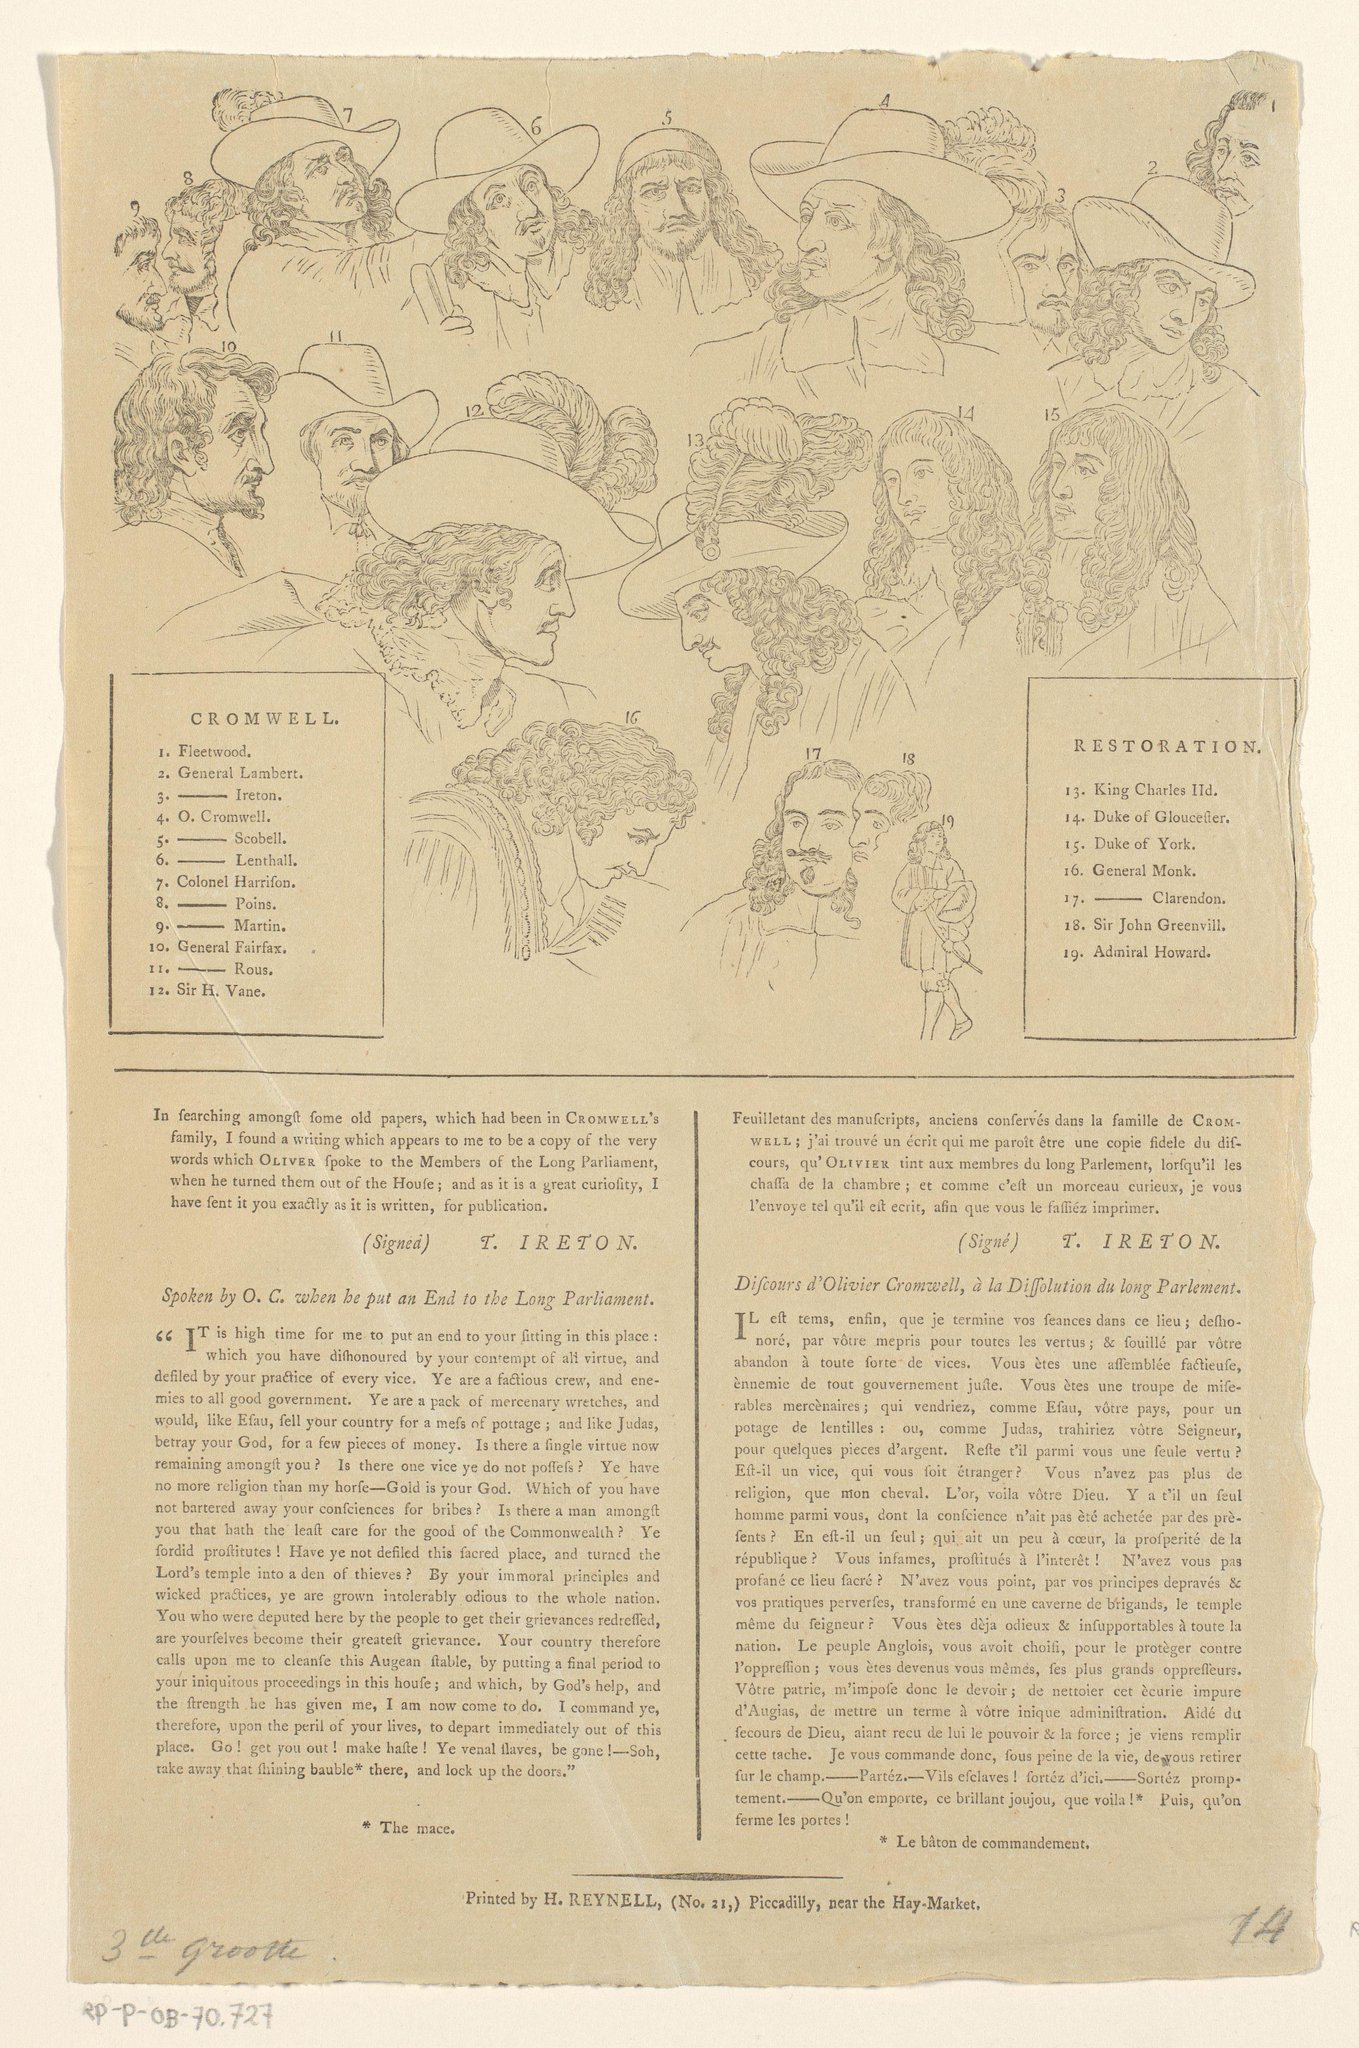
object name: text sheet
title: Toelichting bij de prent waarop Oliver Cromwell het parlement ontbindt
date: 1785-1811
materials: paper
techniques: etching, letterpress printing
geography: london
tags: london, publisher, jacobus ii (koning van engeland en schotland), edward hyde (1e graaf van clarendon), politician, karel ii (koning van engeland), oliver cromwell, historical persons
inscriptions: collector's mark: Lugt 12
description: Legenda met toelichting over de personen in de prent en de tekst in het Engels en het Frans van de vermeende speech die Oliver Cromwell gaf op het moment van zijn overname, waarbij hij leden van het zittende parlement wegstuurde. Genummerd: No. 21.